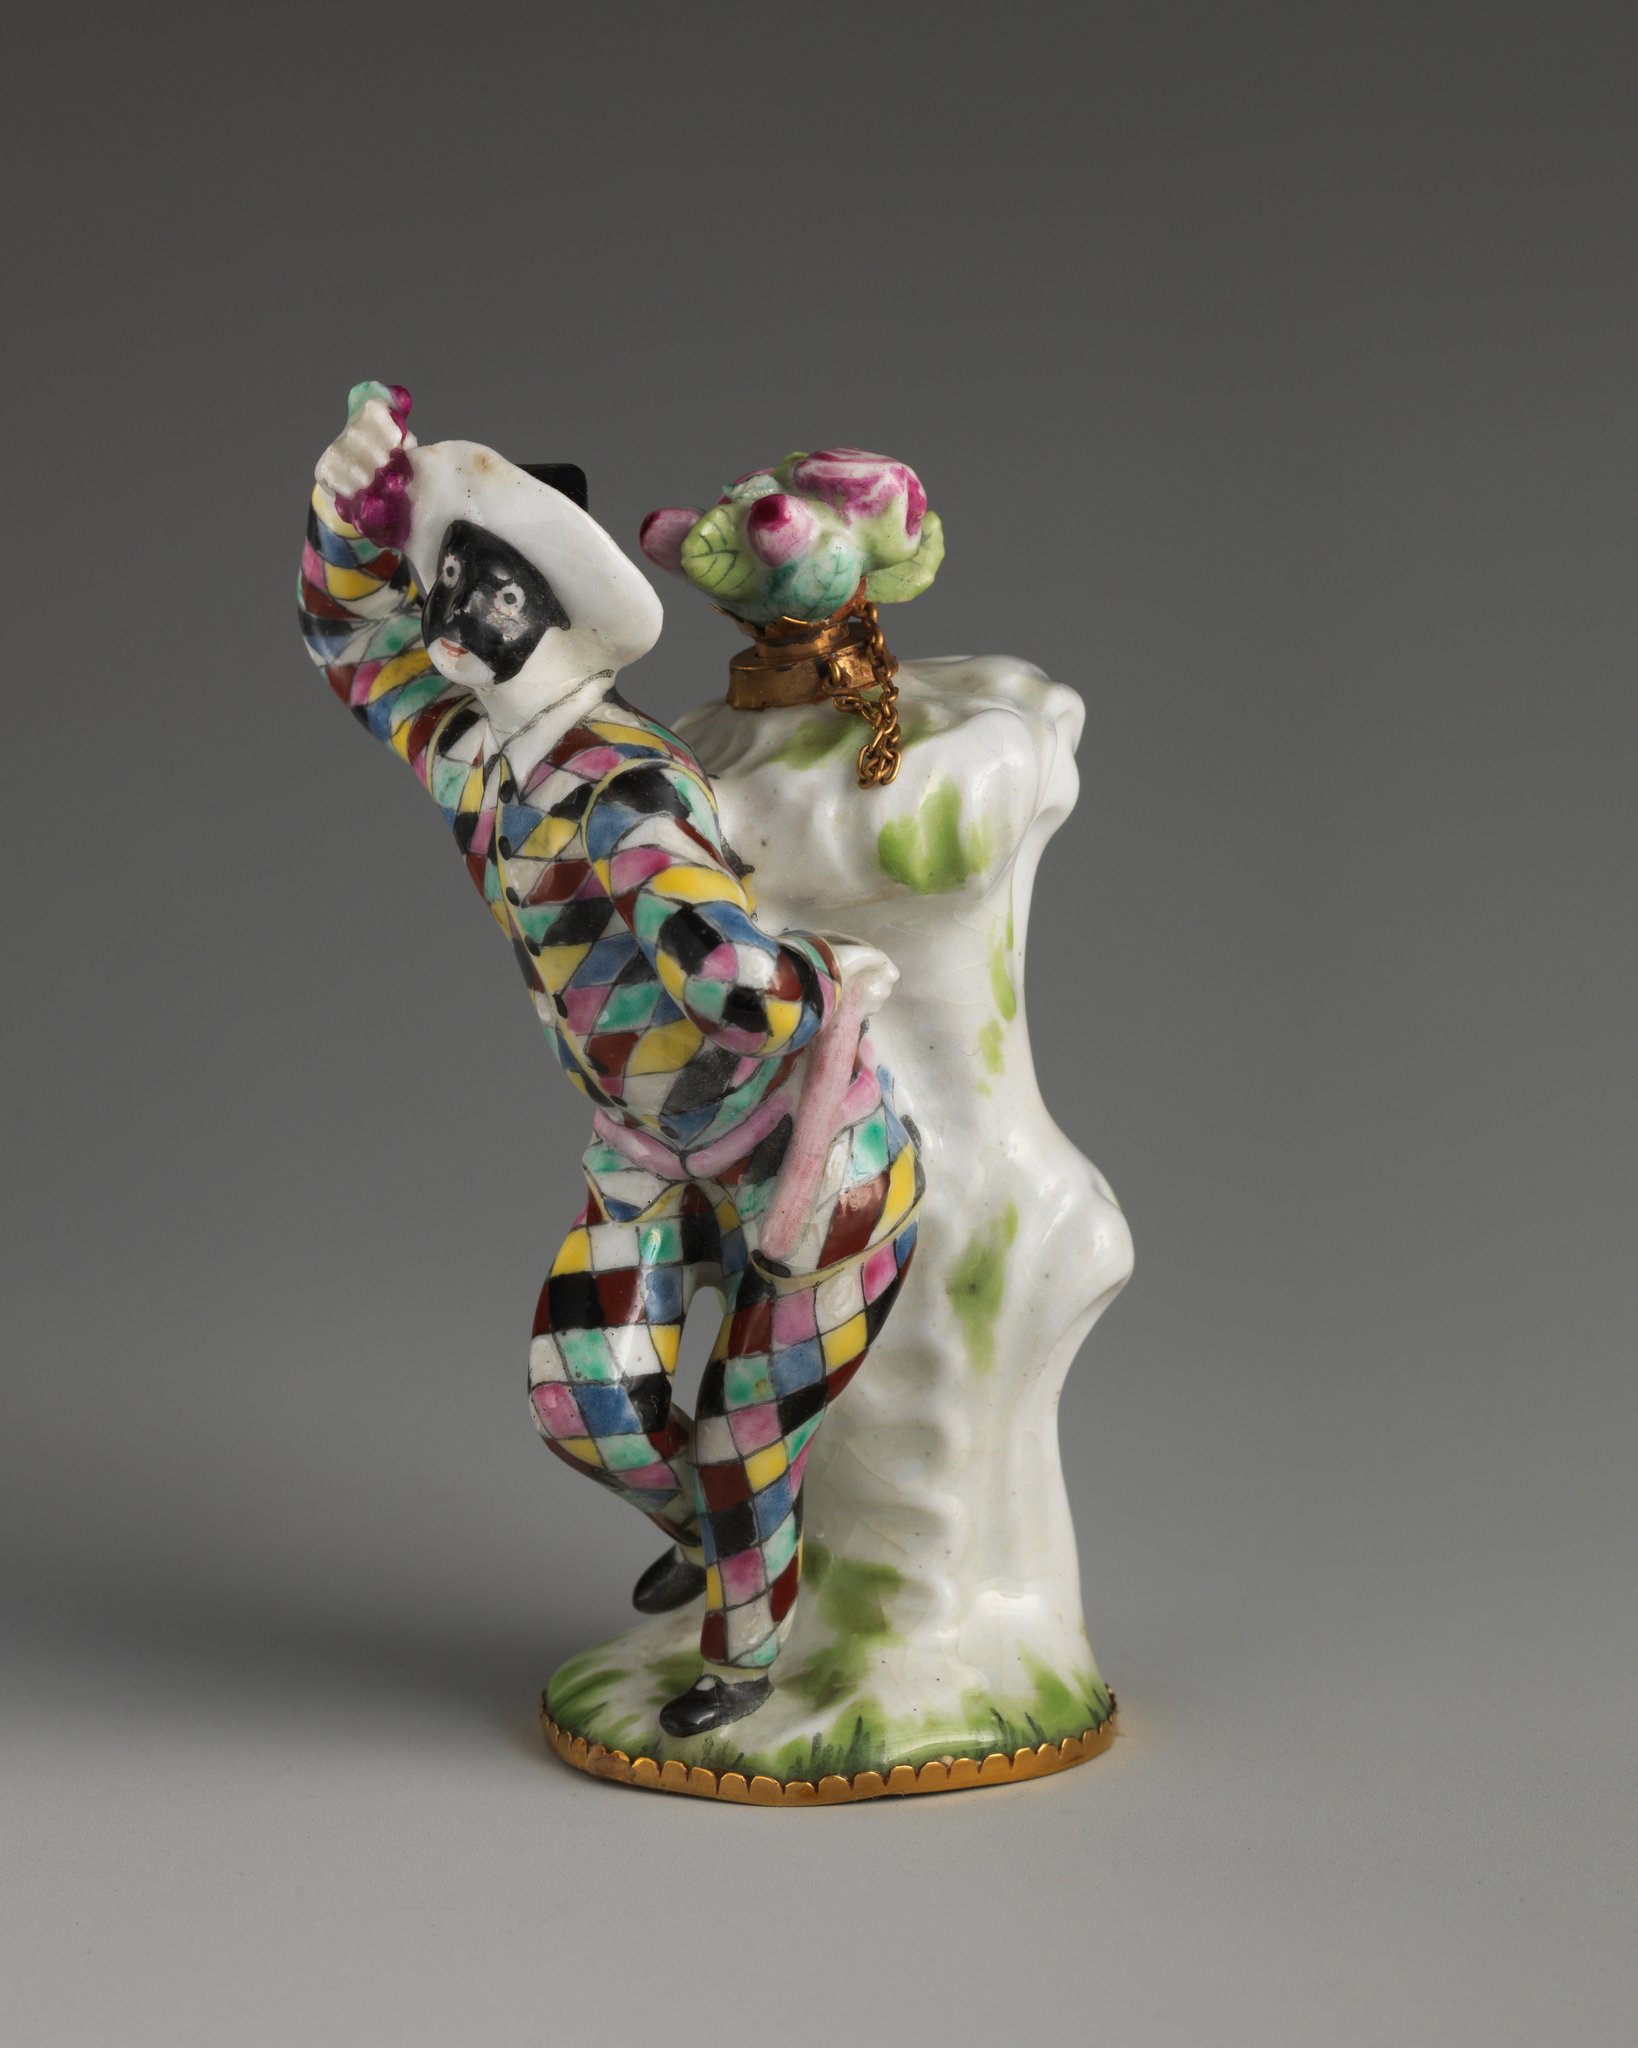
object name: toy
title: Harlequin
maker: chelsea porcelain manufactory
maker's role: factory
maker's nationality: british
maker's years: 1744-1784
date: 1755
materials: soft paste porcelain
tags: masks,men